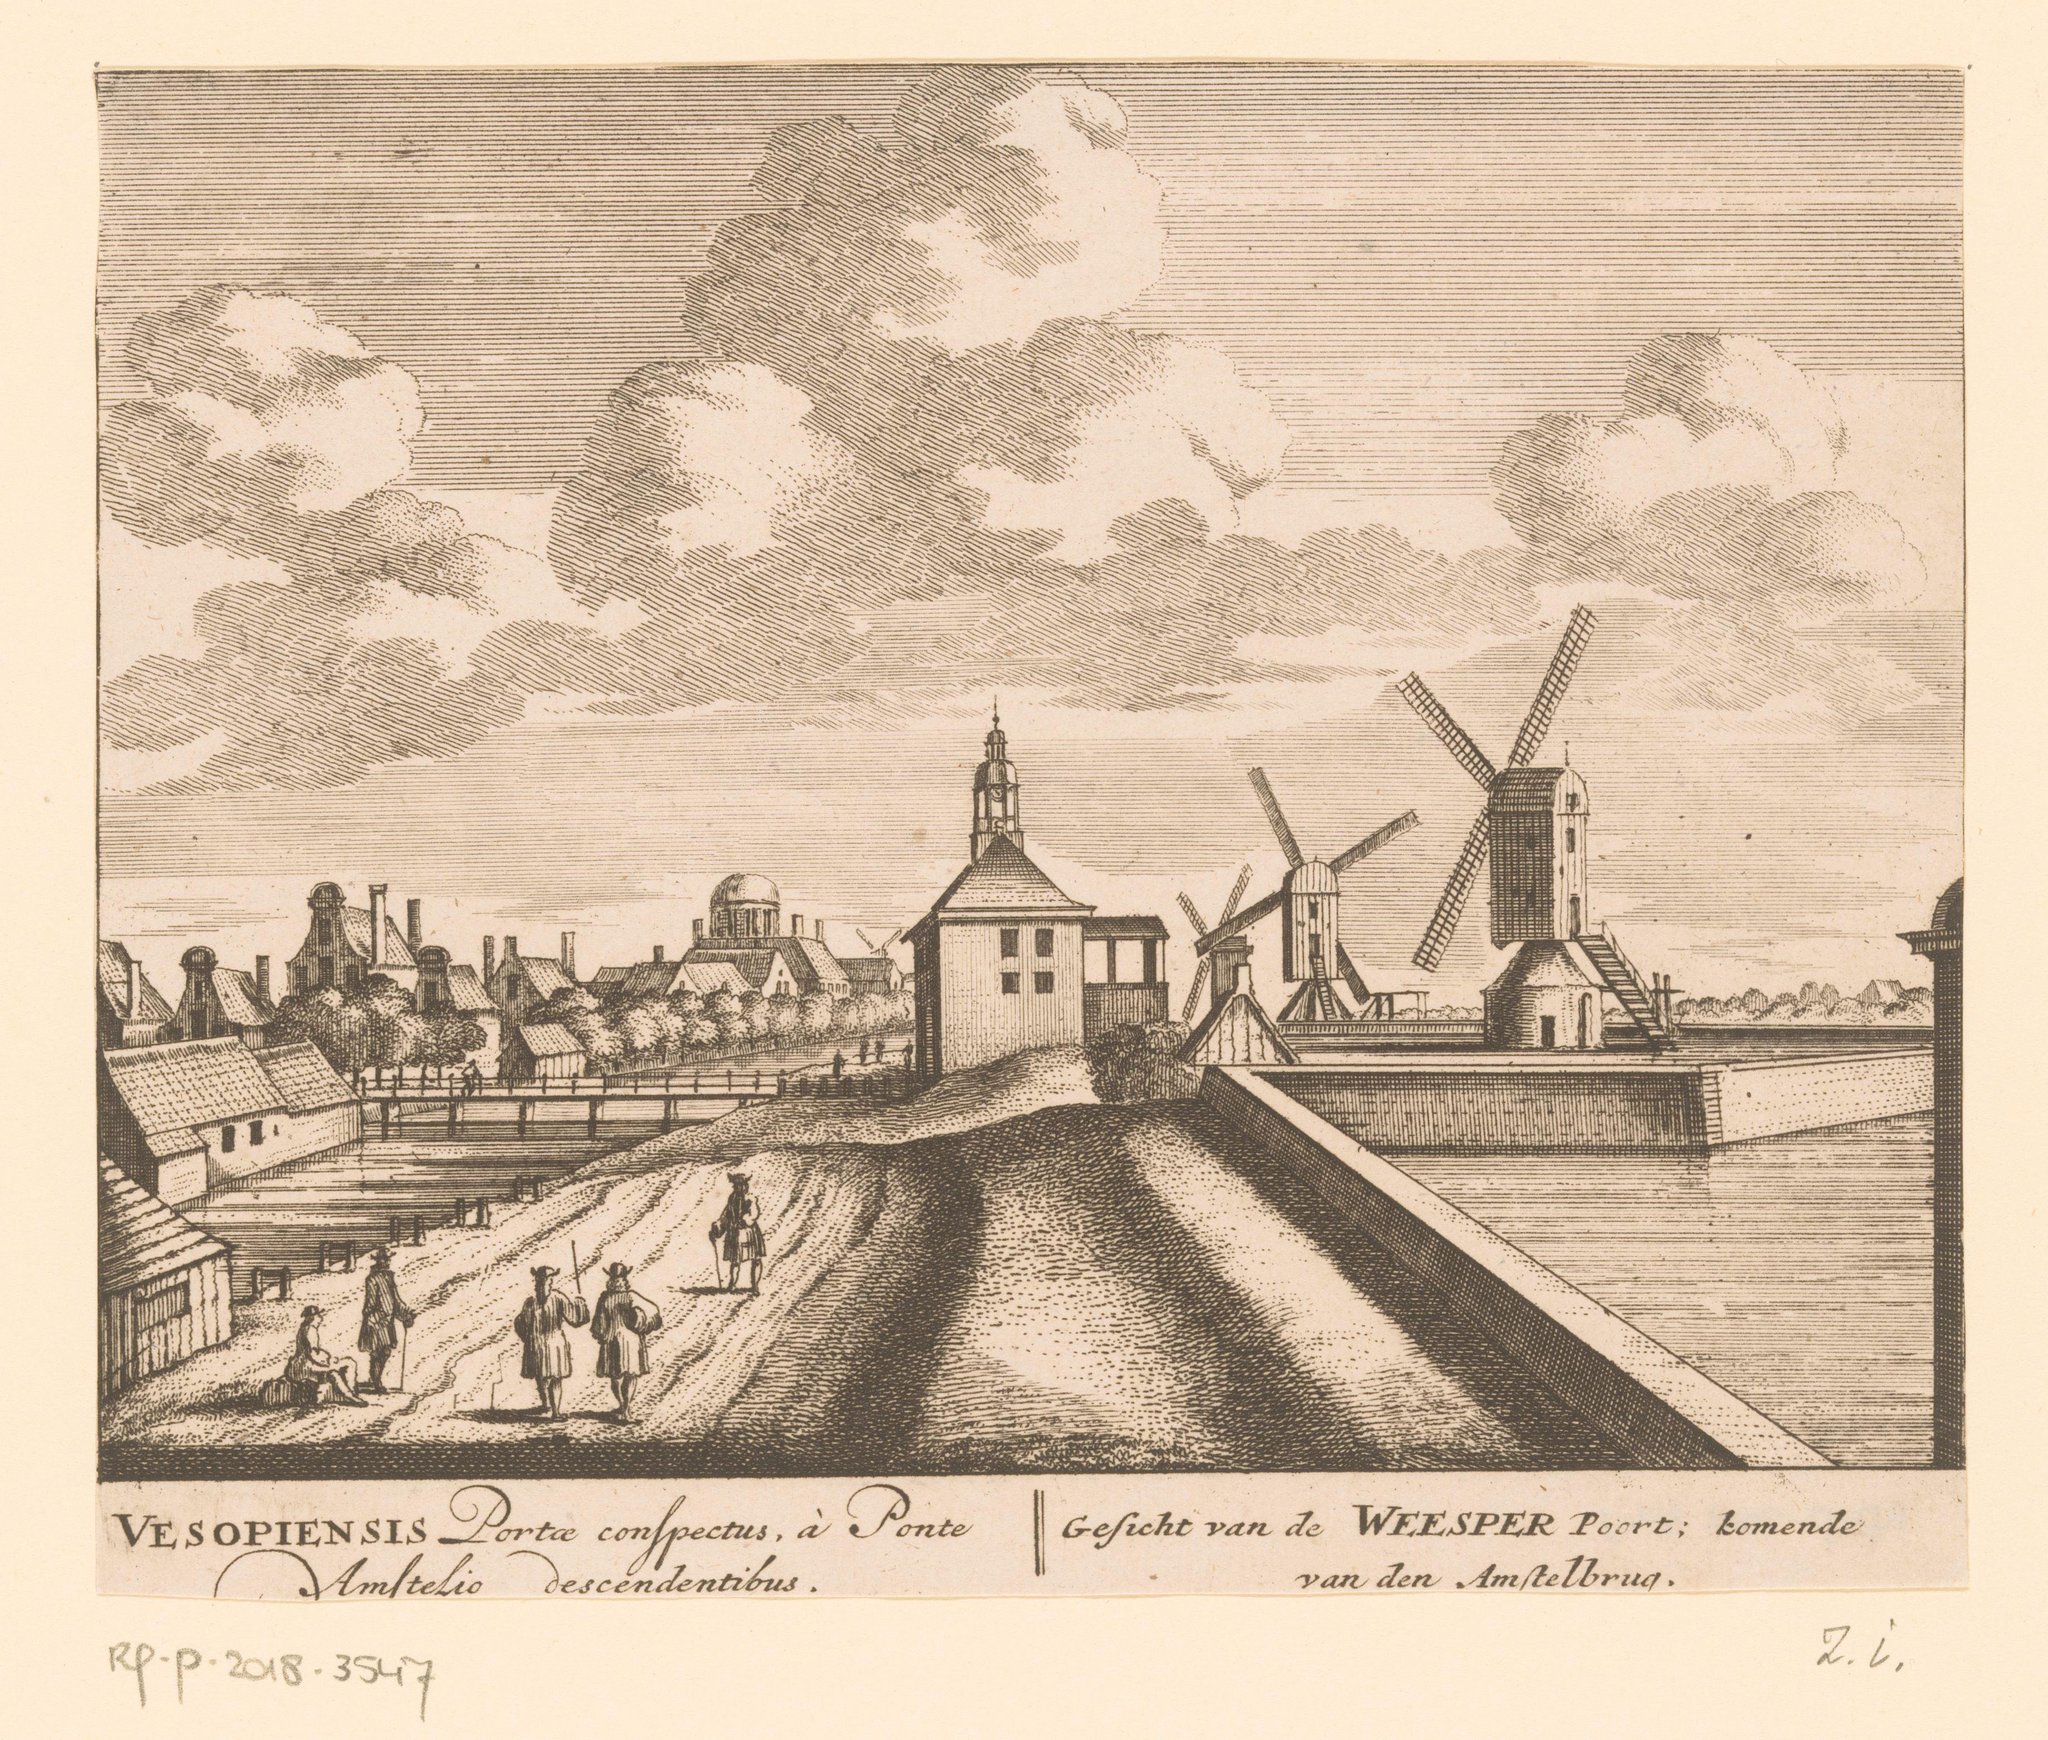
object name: print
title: Gezicht op de Weesperpoort in Amsterdam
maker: Anonymous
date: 1710-1711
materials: paper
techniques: engraving, etching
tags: windmill in landscape, city-gate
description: Prent uit: 100 Afbeeldinge der voornaamste gebouwen van Amsterdam. Amsterdam, Pieter Schenk (I), [1710-1711]. Of: 100 Afbeeldinge der voornaamste gebouwen van Amsterdam. Amsterdam, Barent Greve, [1757-1766], prent nummer 39. In de tweede uitgave, uitgegeven door Barent Greve, is alleen de titelprent aangepast. De overige prenten zijn onveranderd gebleven.